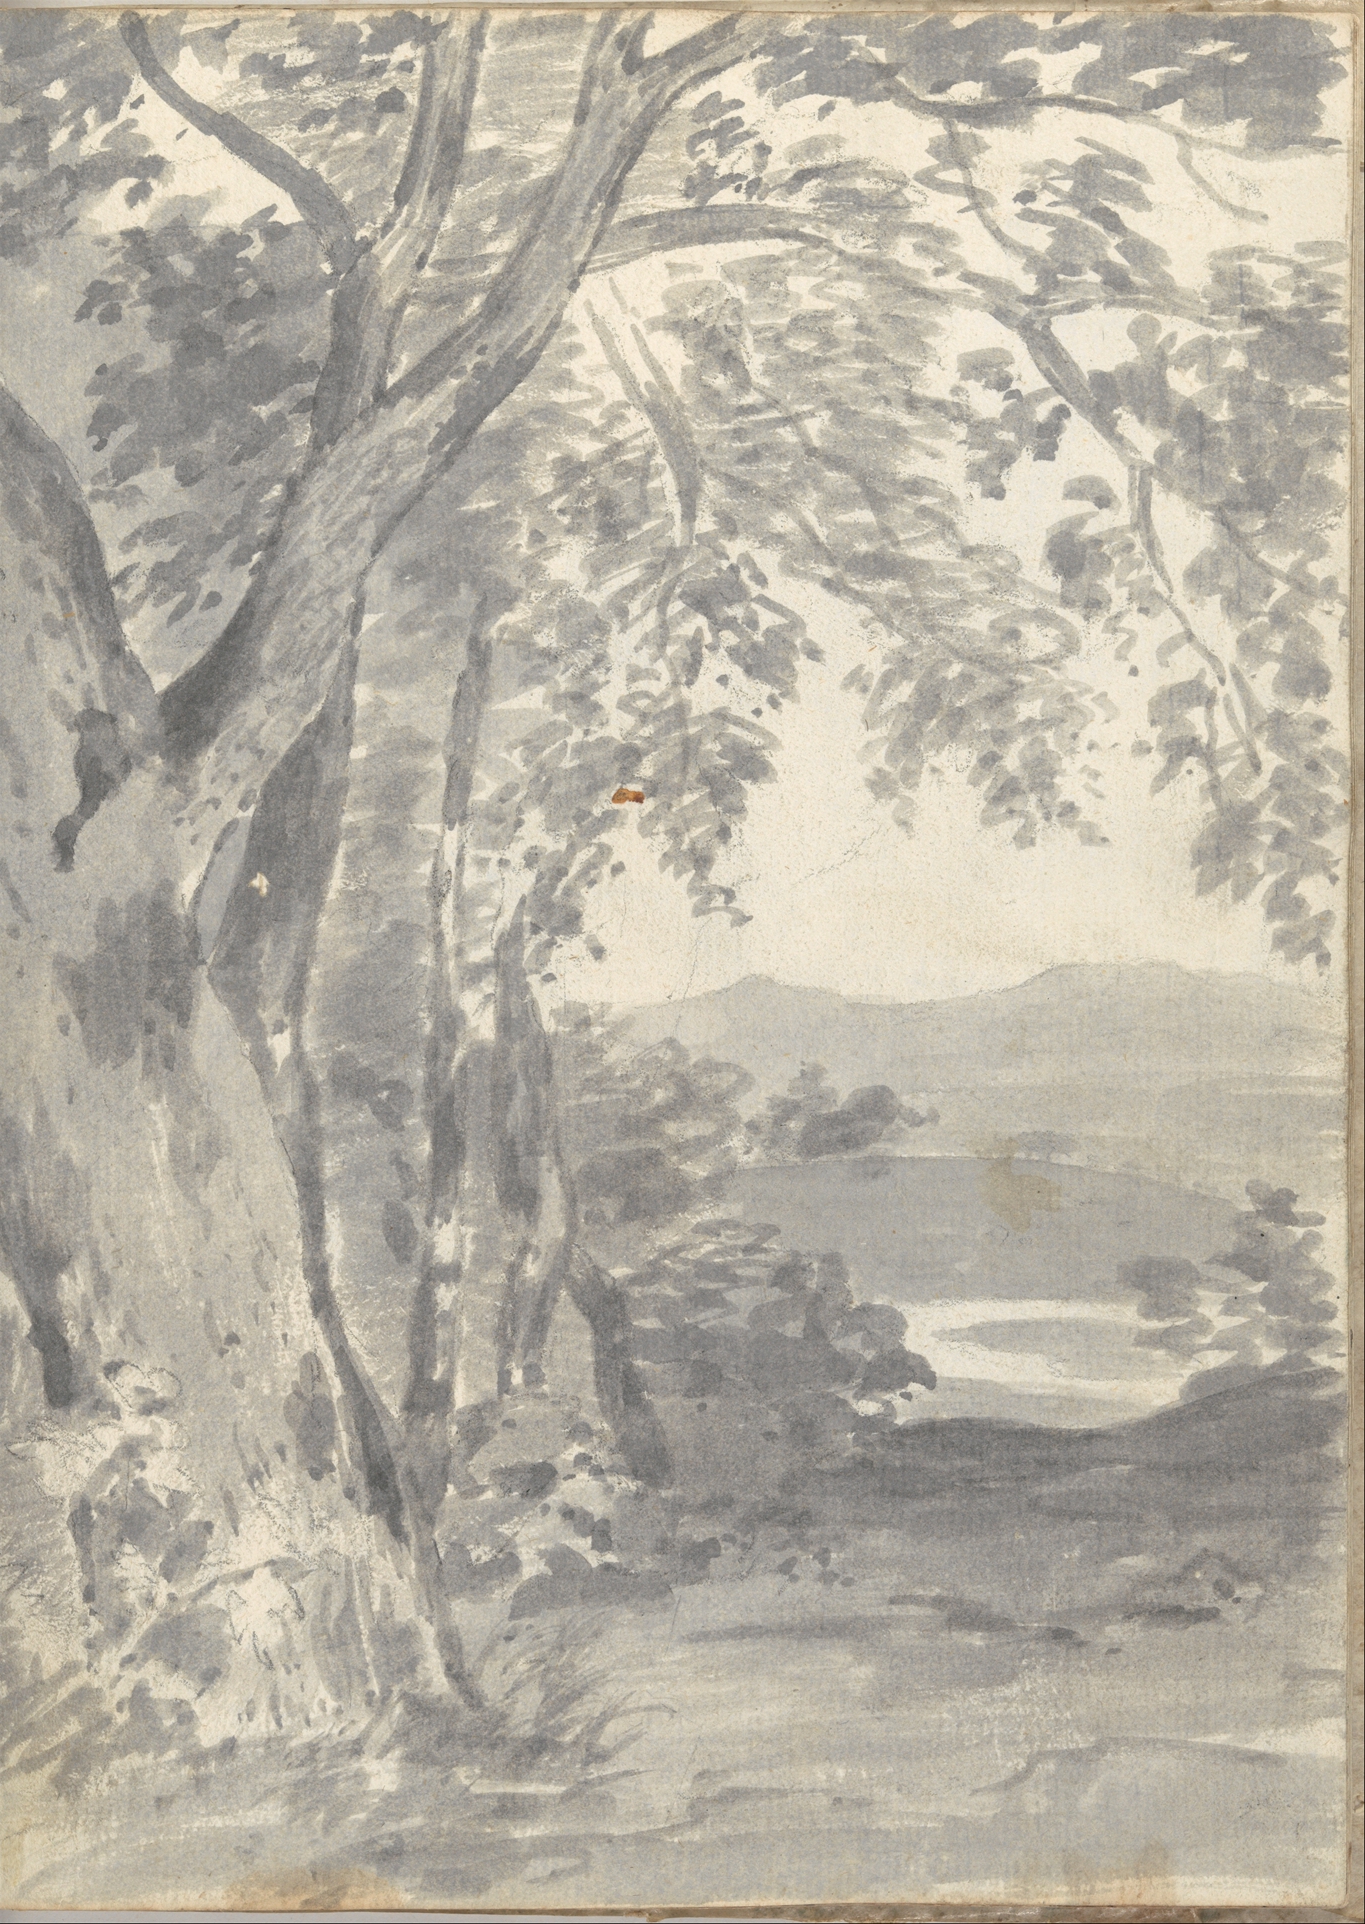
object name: drawing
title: Landscape with trees and distant hills (Smaller Italian sketchbook, leaf 37 recto)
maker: joseph wright (wright of derby)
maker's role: artist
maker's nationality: british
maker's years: 1734-1797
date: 1774-1775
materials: ink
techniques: brush, wash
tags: landscapes,trees